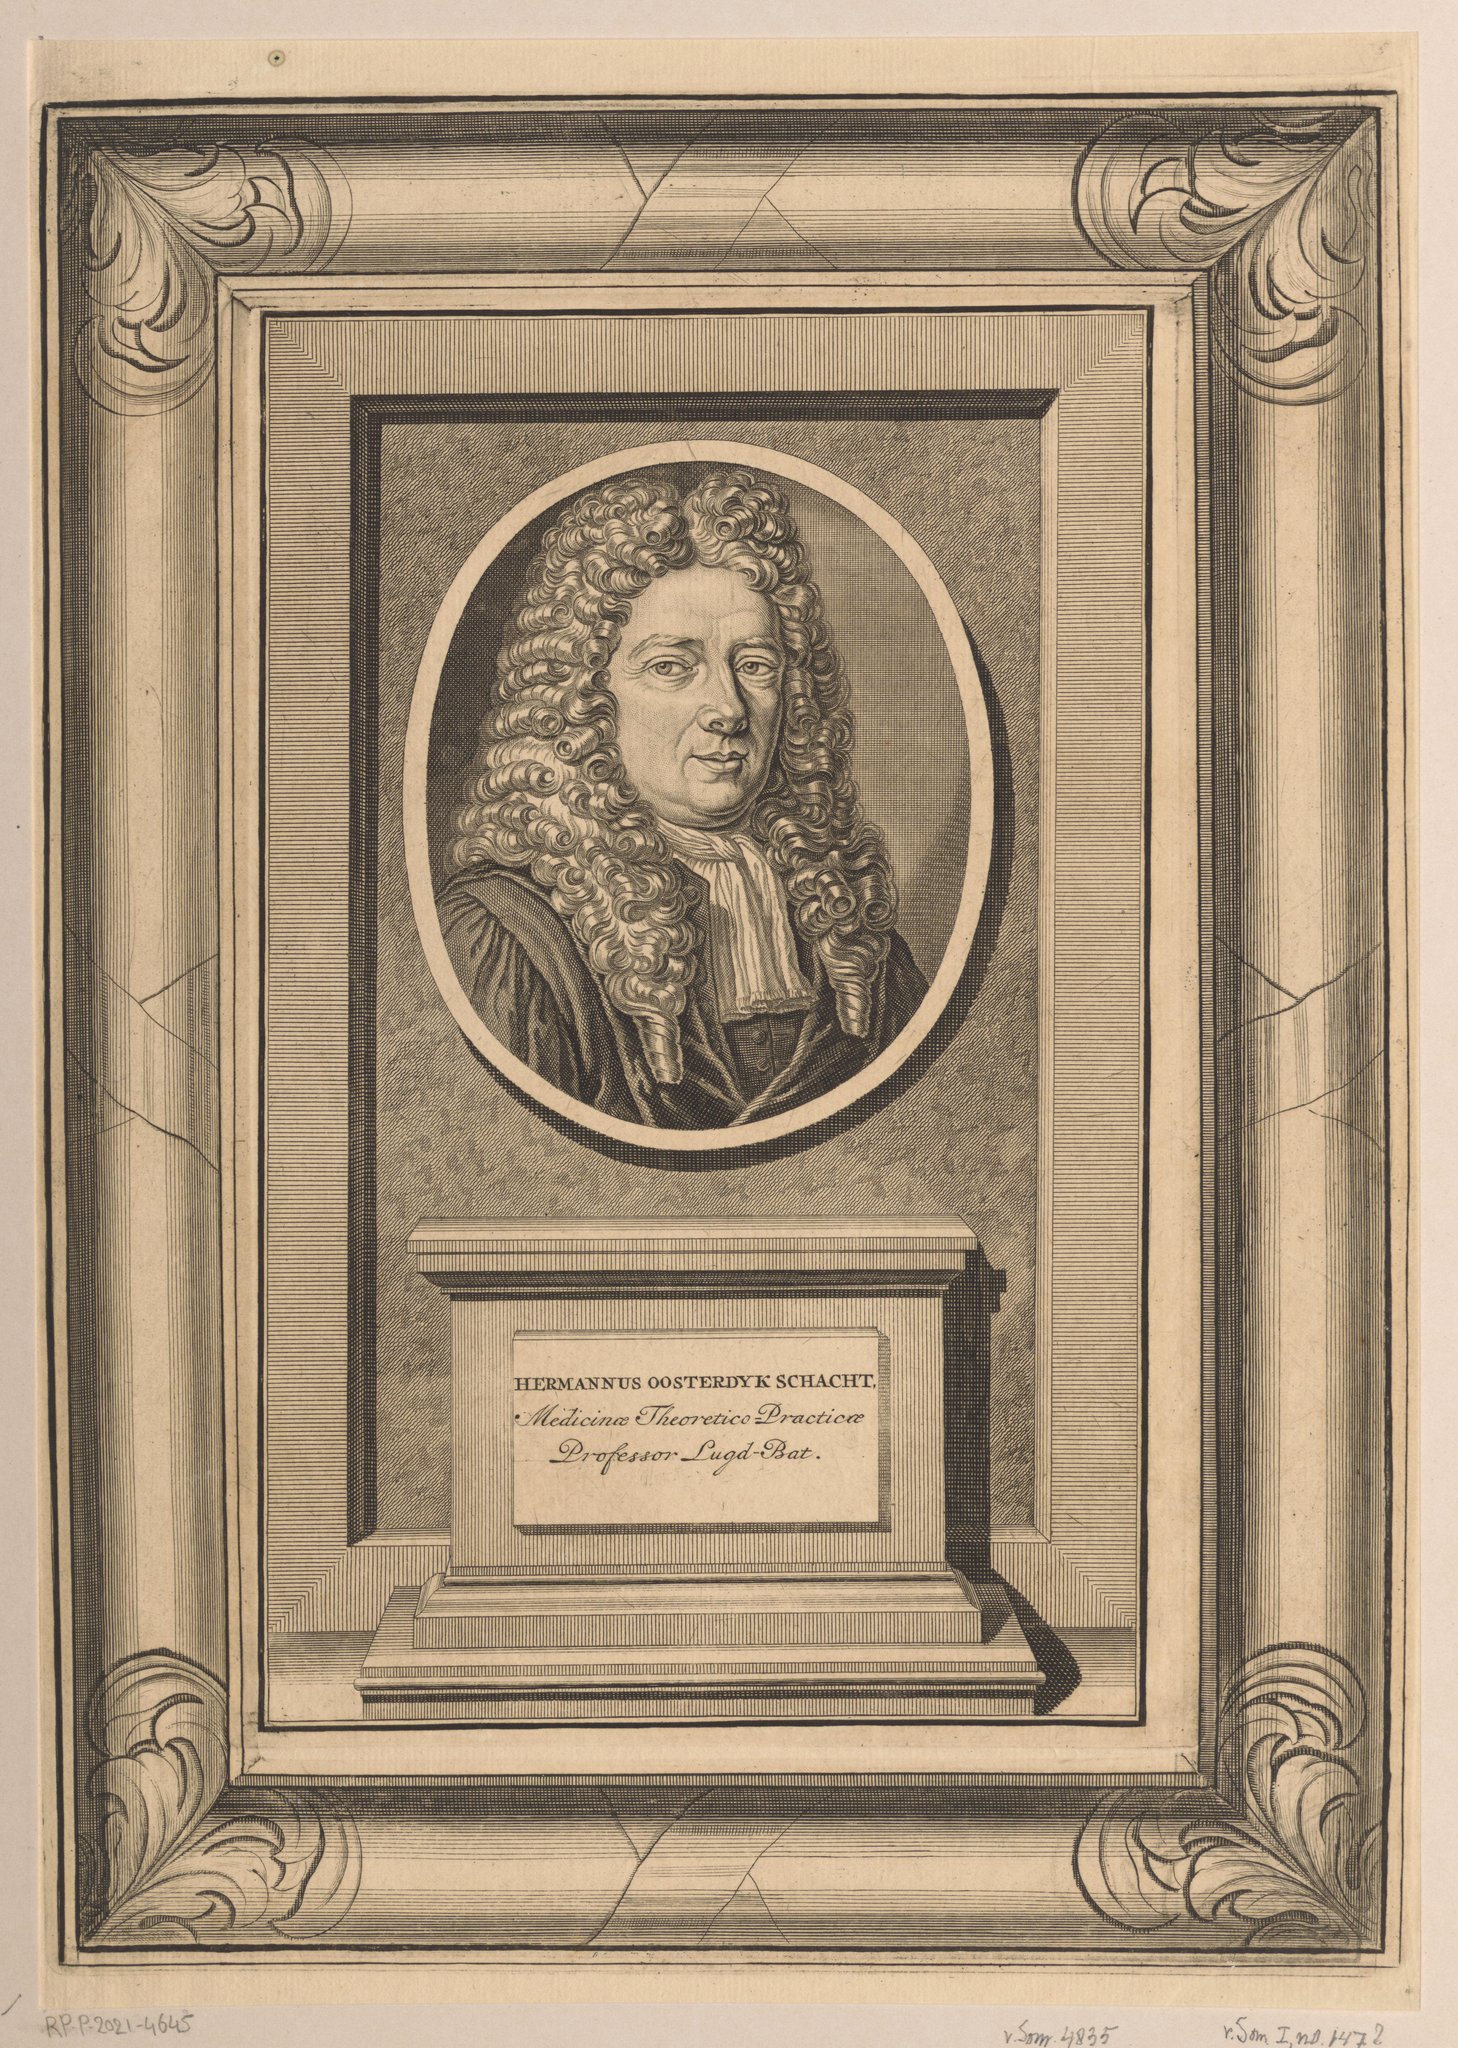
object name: print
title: Portret van Hermannus Oosterdijk Schacht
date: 1668-1733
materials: paper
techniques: engraving, etching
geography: leiden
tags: amsterdam, historical persons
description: Prent met enkele omlijsting gebruikt in: Fundatoris, curatorum et professorum celeberrimorum (...). Leiden: Pieter van der Aa, 1716. Eerdere staat van het portret voor het eerst gebruikt in: Icones ad vivum delineatae et expressae. Leiden: Andries Clouck, 1609. Eerdere staat ook gebruikt in: Meursius, Joannes. Illustris academia Lugd-Batava (...). Leiden: Andries Clouck, 1613; Meursius, Joannes. Icones, elogia ac vitae professorum Lugdunensium apud Batavos (...). Leiden: Andries Clouck, 1617 en in: Meursius, Joannes. Athenae Batavae. Sive, de urbe Leidensi & academia, virisuw claris (...). Leiden: Andries Clouck en Bonaventura en Abraham Elzevier, 1625.